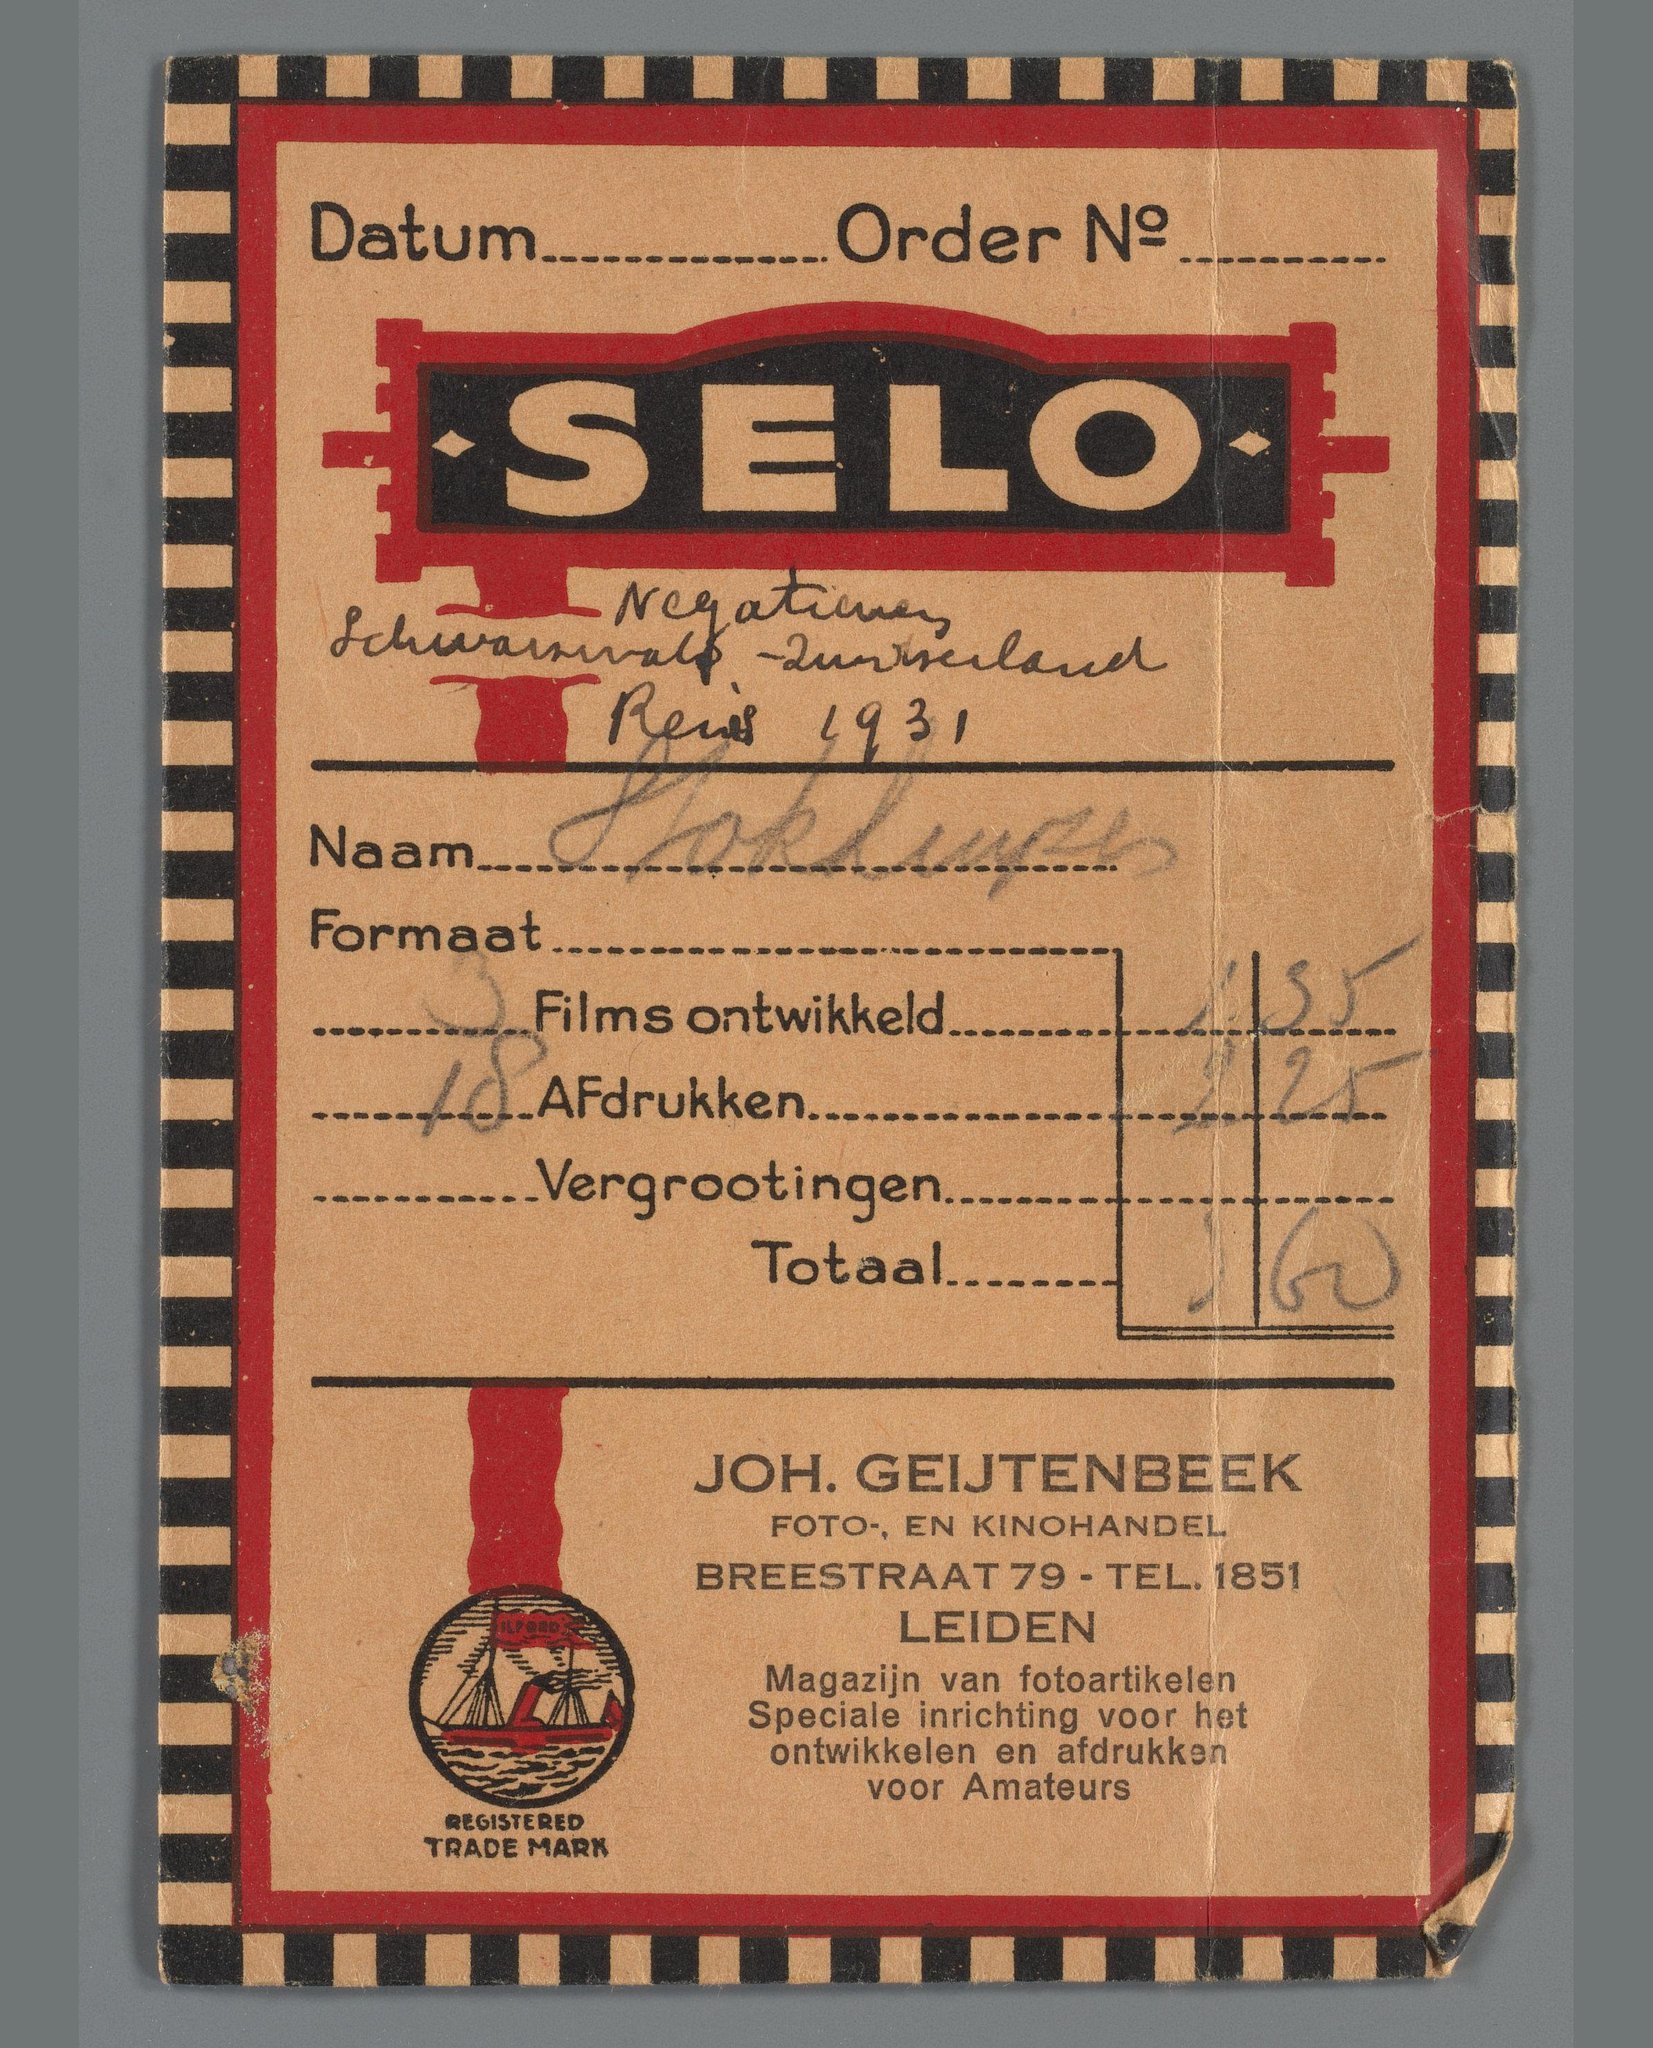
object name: print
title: Verpakking voor Ilford Selo fotoafdrukken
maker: Anonymous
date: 1933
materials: cardboard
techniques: letterpress printing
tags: storing, conserving, preserving (of products), printing ~ film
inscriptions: inscription: ‘Negatieven/ Schwarzwald-Zwitserland/ Reis 1931’, date: ‘1933’, name: ‘Stokhuyzen’, address: ‘JOH. GEIJTENBEEK/ FOTO- EN KINOHANDEL/ BREESTRAAT 79 - TEL. 1851/ LEIDEN’